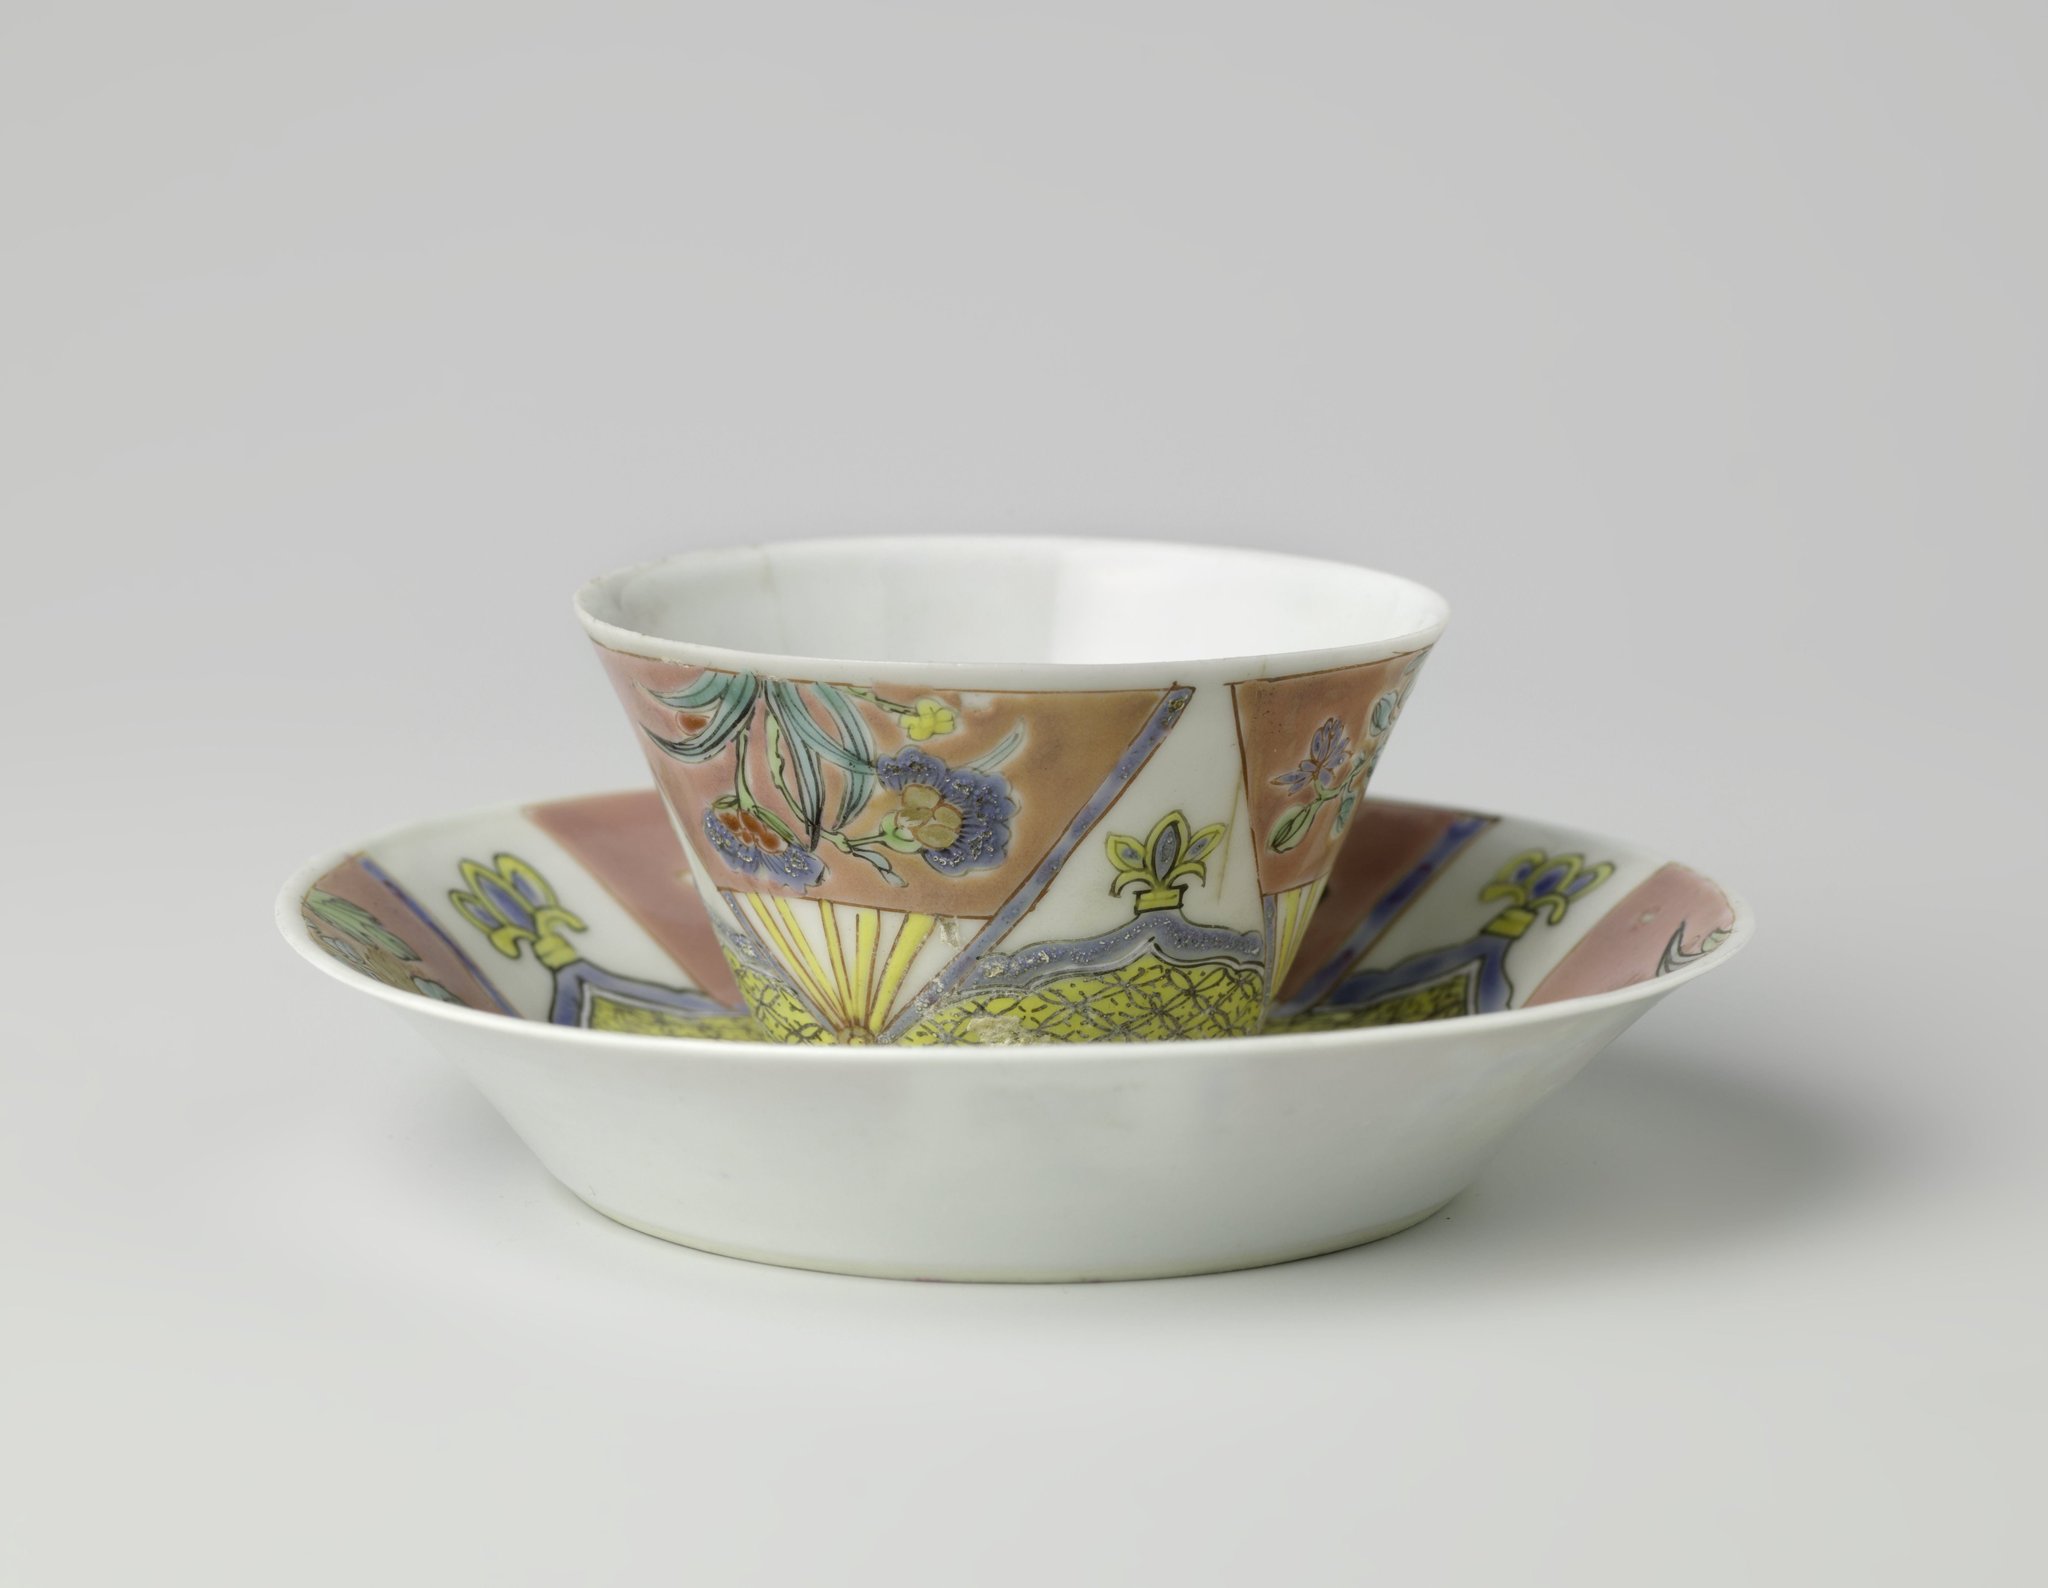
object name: kop en schotel, kop en schotel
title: Cup and saucer with cock and three fans with flower sprays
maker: Anonymous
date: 1725-1749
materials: glaze, gold, paint, porcelain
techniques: firing, gilding, turning, vitrification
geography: china